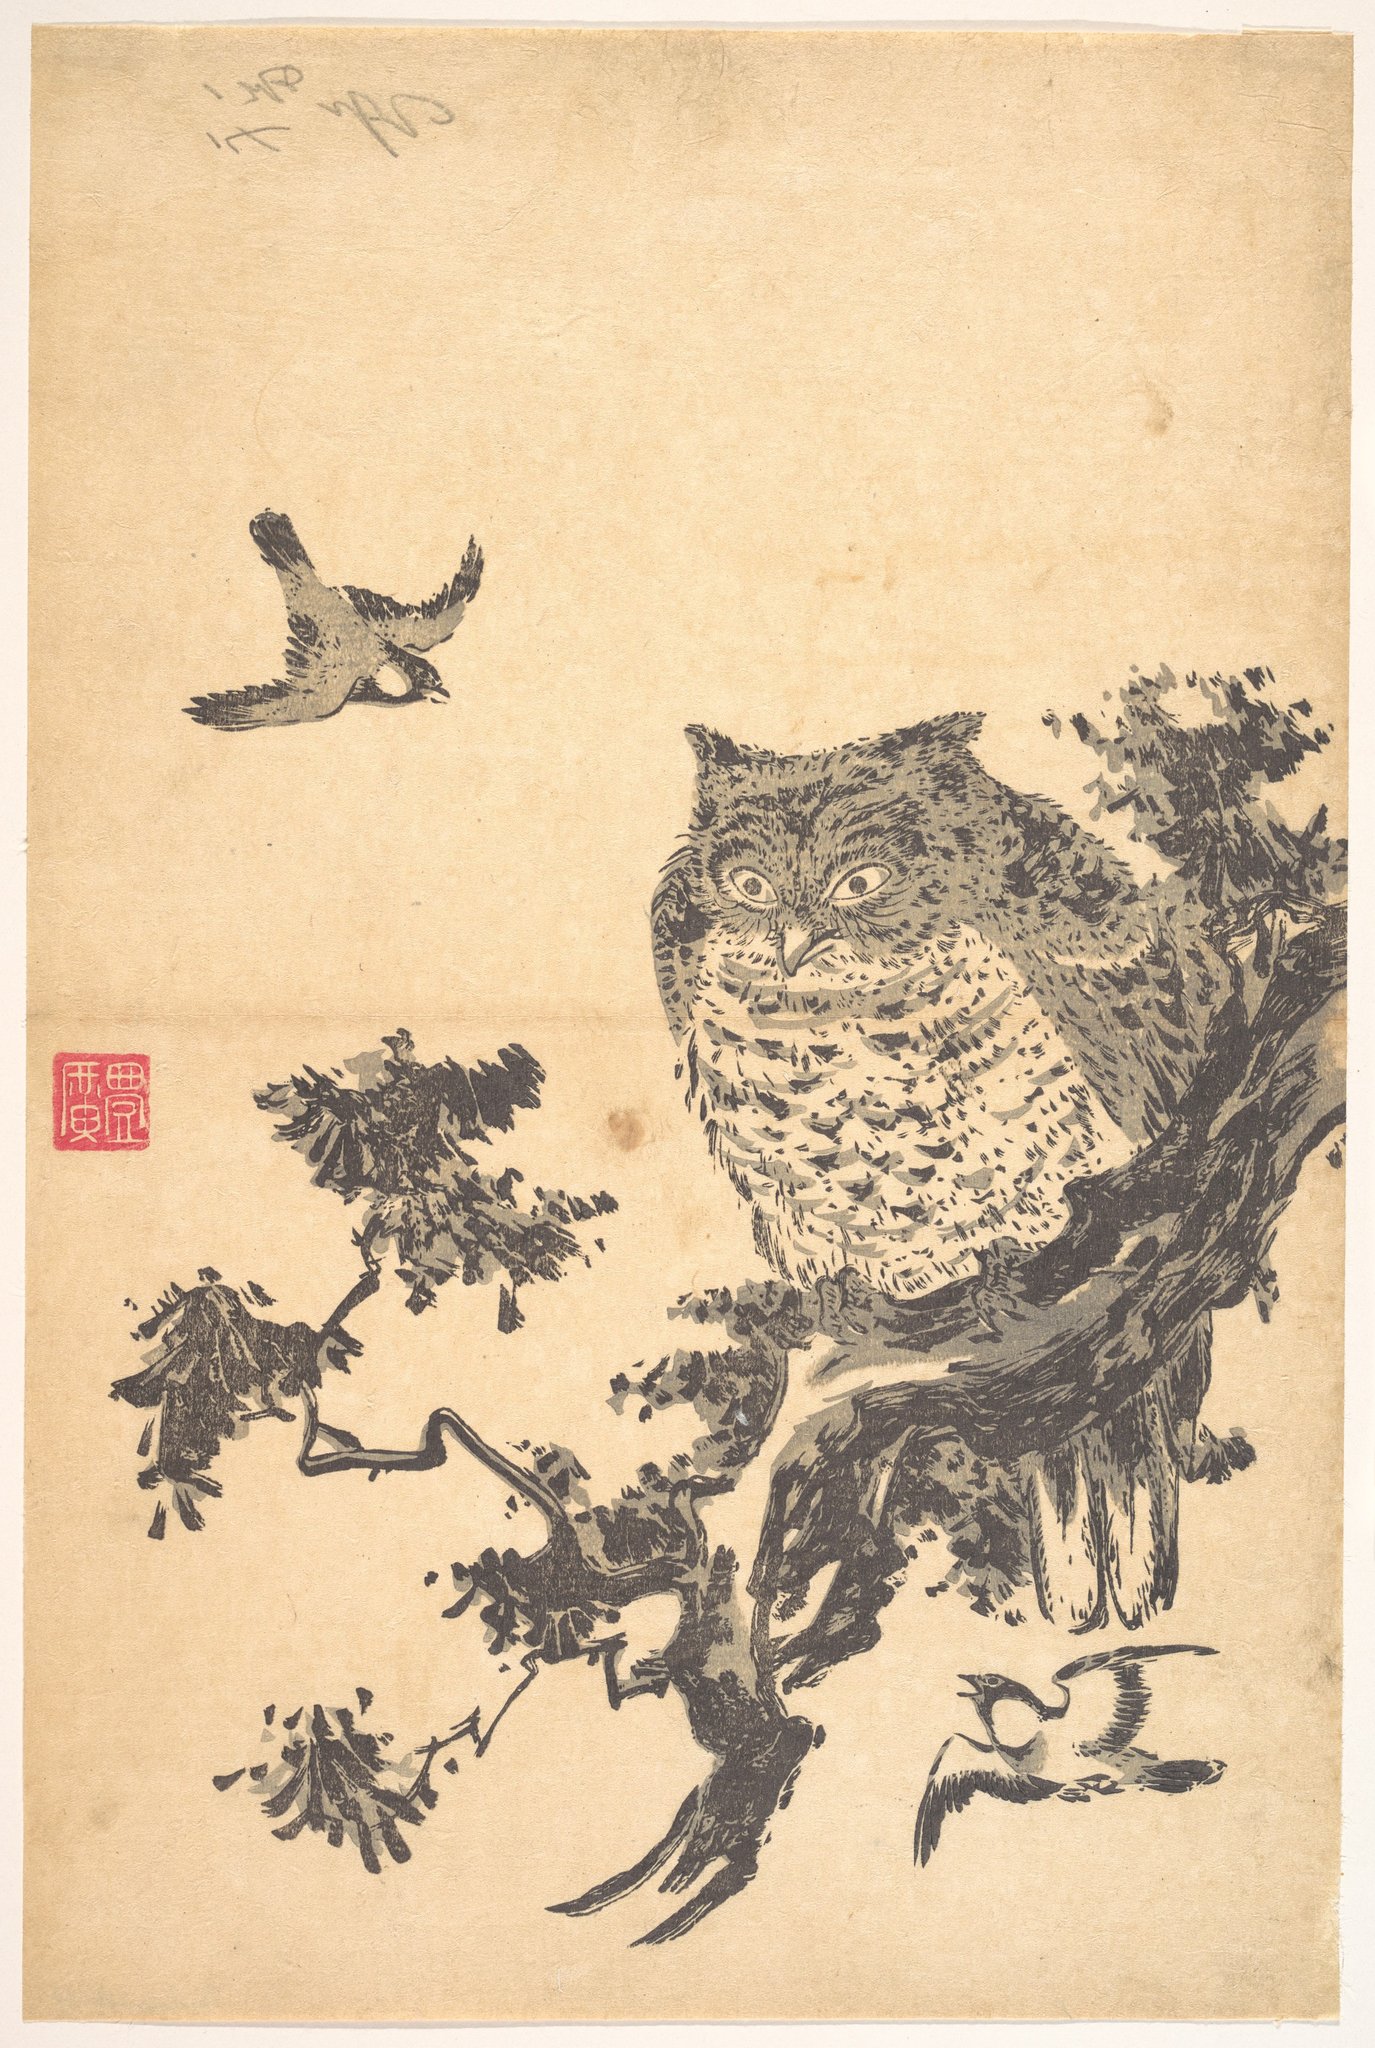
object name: print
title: Owl and Two Swallows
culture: japanese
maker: utagawa toyohiro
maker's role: artist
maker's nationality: japanese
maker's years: 1763-1828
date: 1763-1828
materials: ink, paper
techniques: woodblock print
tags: birds,owls,trees